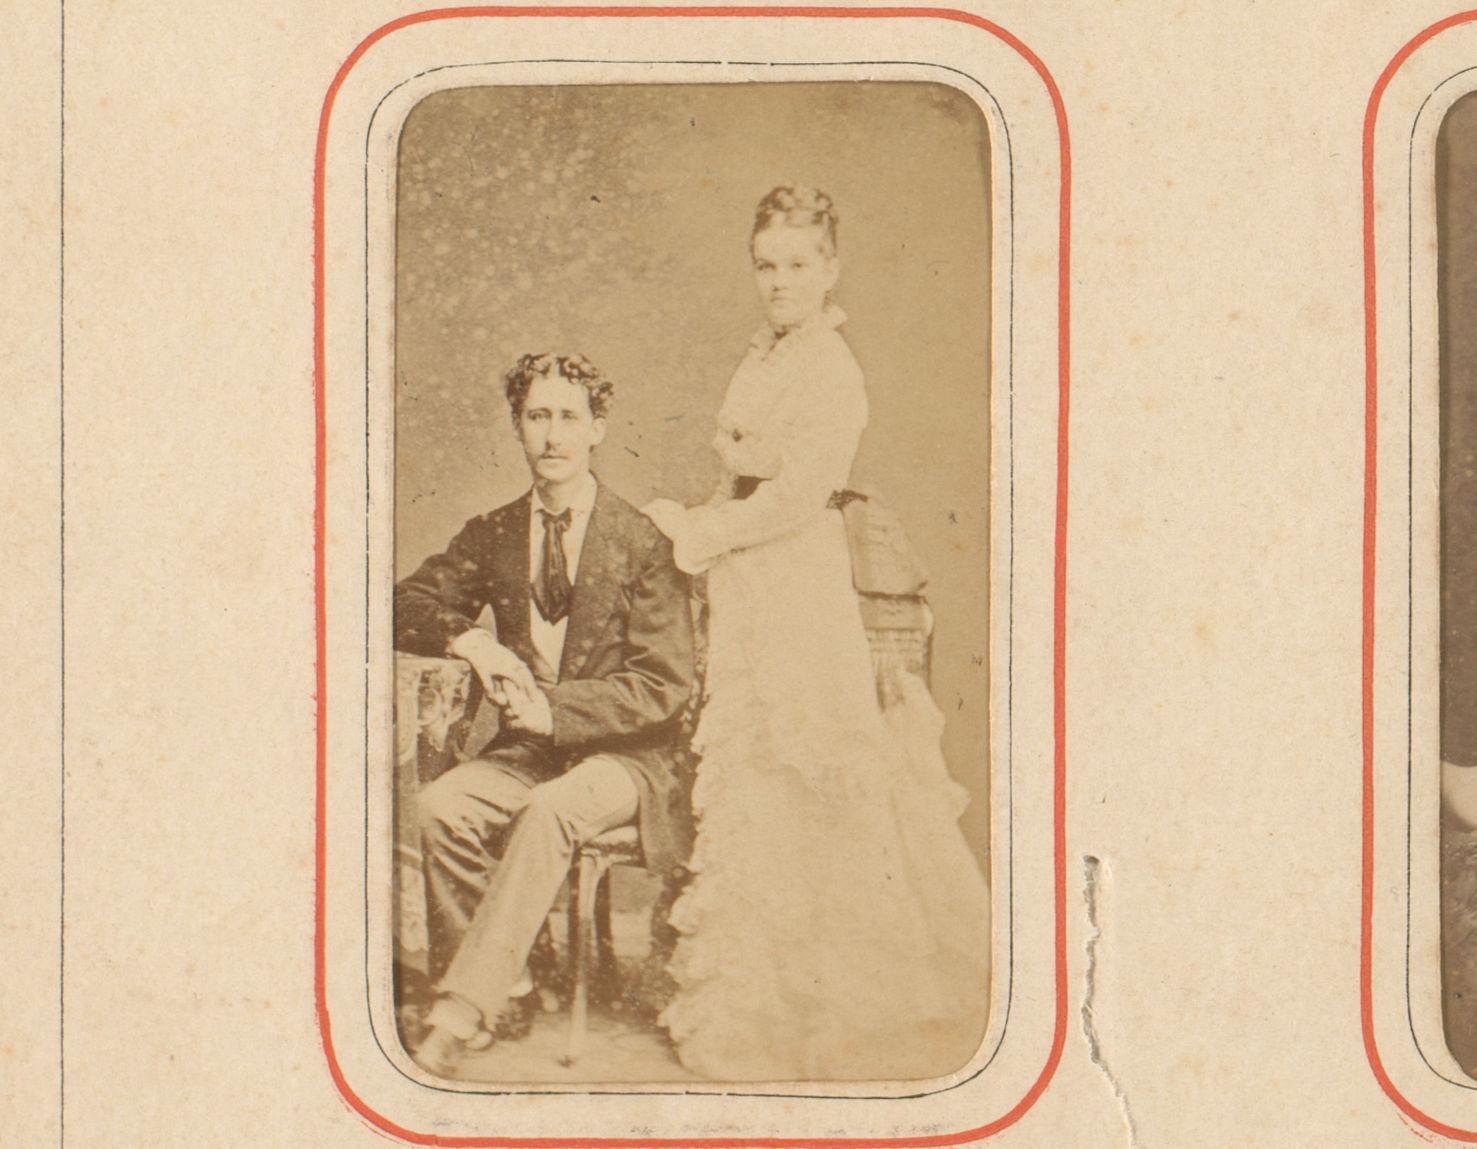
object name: album leaf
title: Portret van twee mensen, mogelijk Margo de Lange en August Kessler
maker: albert greiner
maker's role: fotograaf, fotostudio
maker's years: 1833-1890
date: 1874-1887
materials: cardboard, paper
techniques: albumen print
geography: amsterdam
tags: margaretha jacoba johanna kessler-de lange (margo), batavia, naples, jean baptiste august kessler (1853-1900), historical persons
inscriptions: address: ‘AMSTERDAM/ NIEUWENDIJK. L. 89’